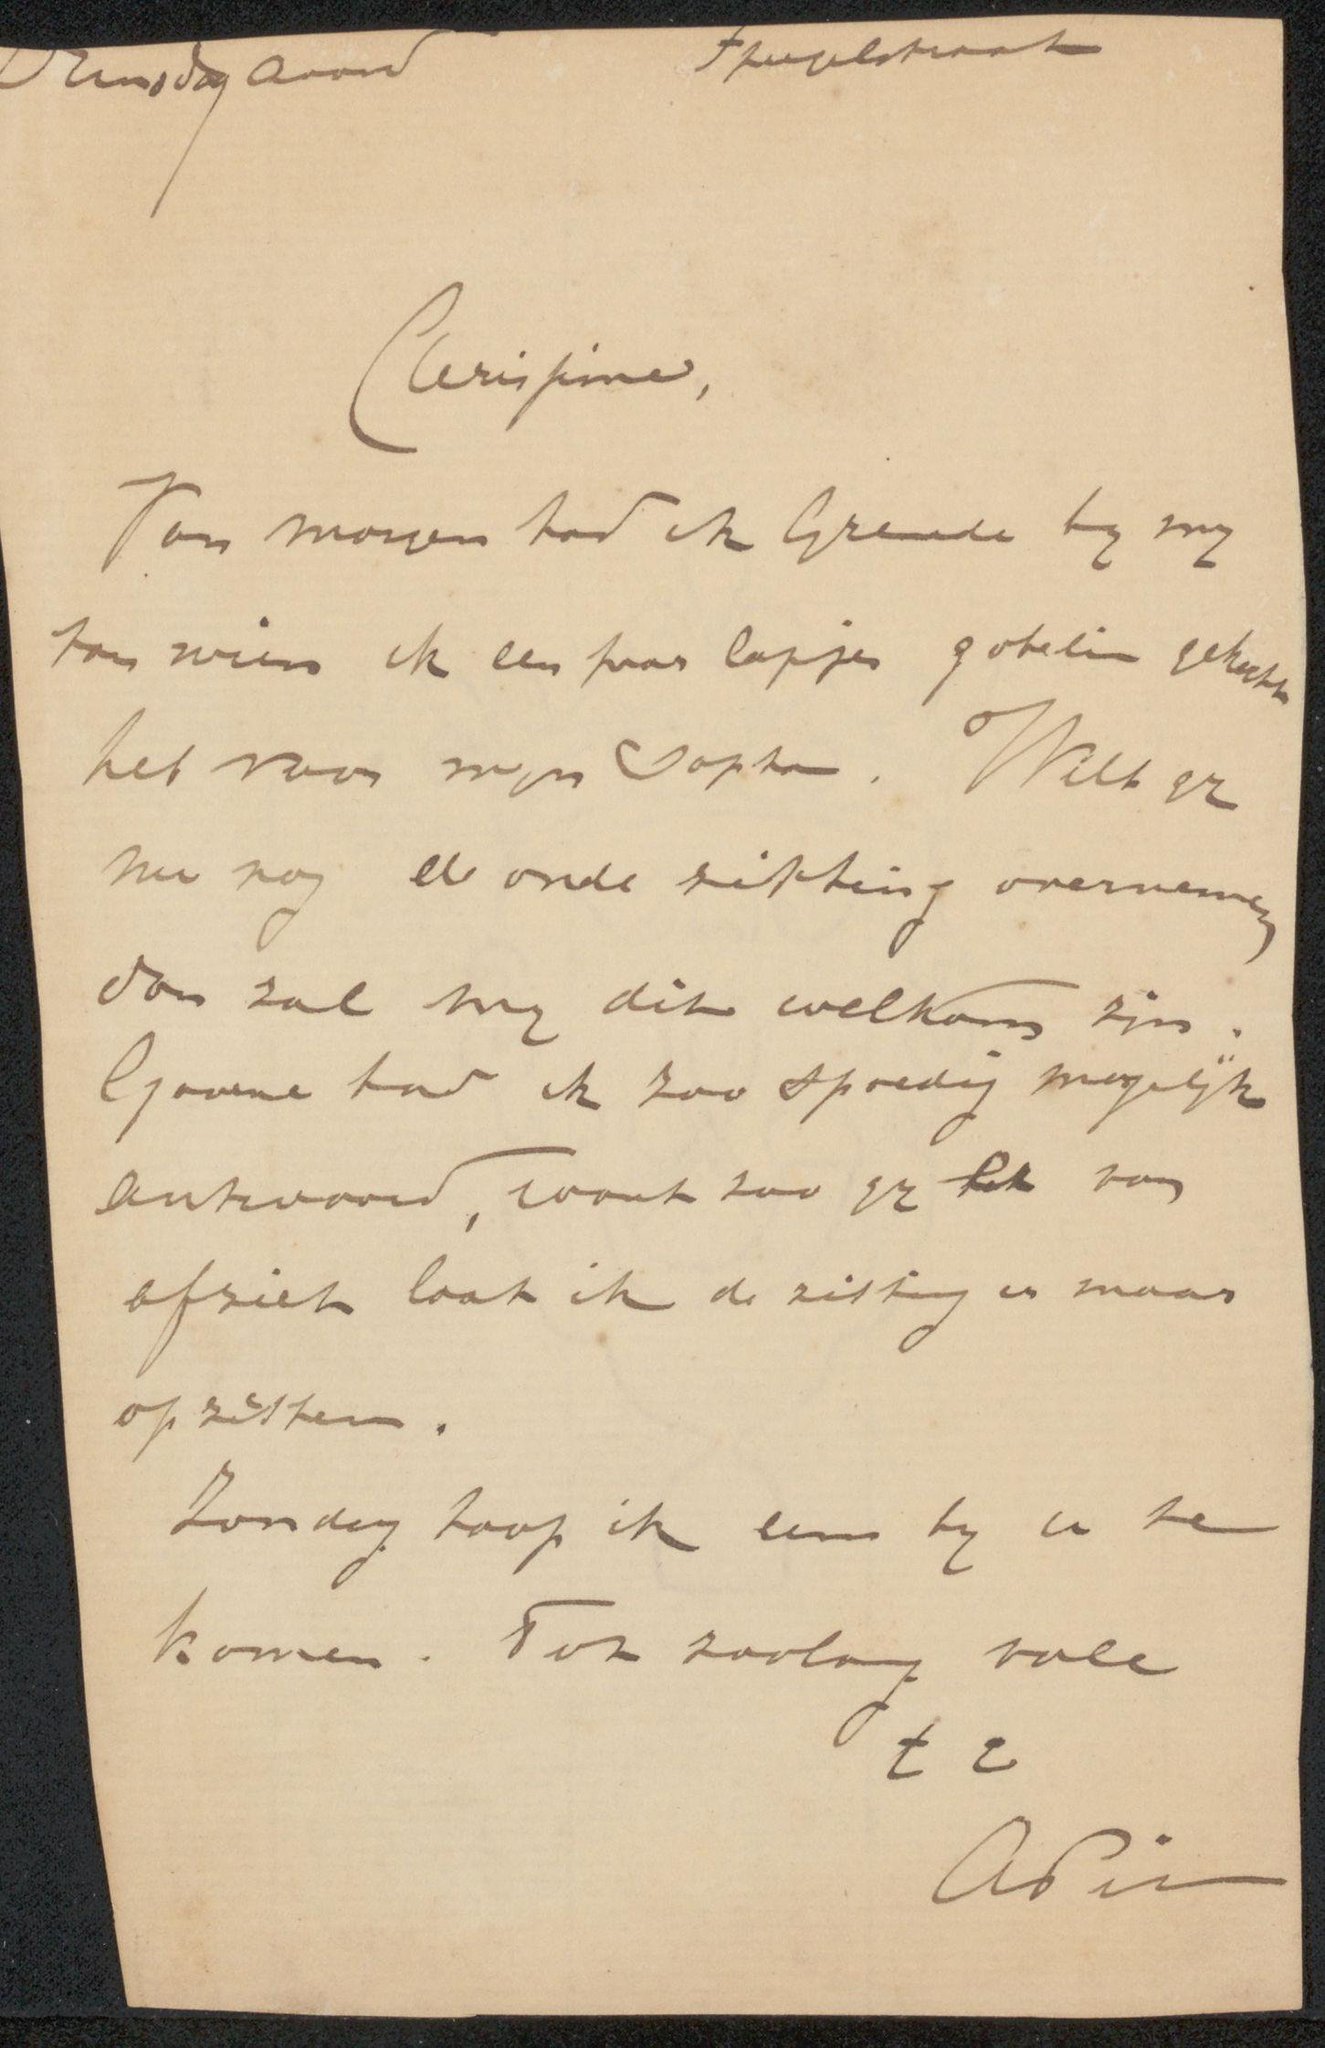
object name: letter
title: Brief aan Philip Zilcken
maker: adriaan pit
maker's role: print maker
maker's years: 1860-1944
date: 1870-1930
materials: ink, paper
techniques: pen, writing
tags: the hague, painter, draughtsman, philip zilcken, applied arts, arts and crafts; industrial design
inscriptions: collector's mark: ‘RPK’, watermark